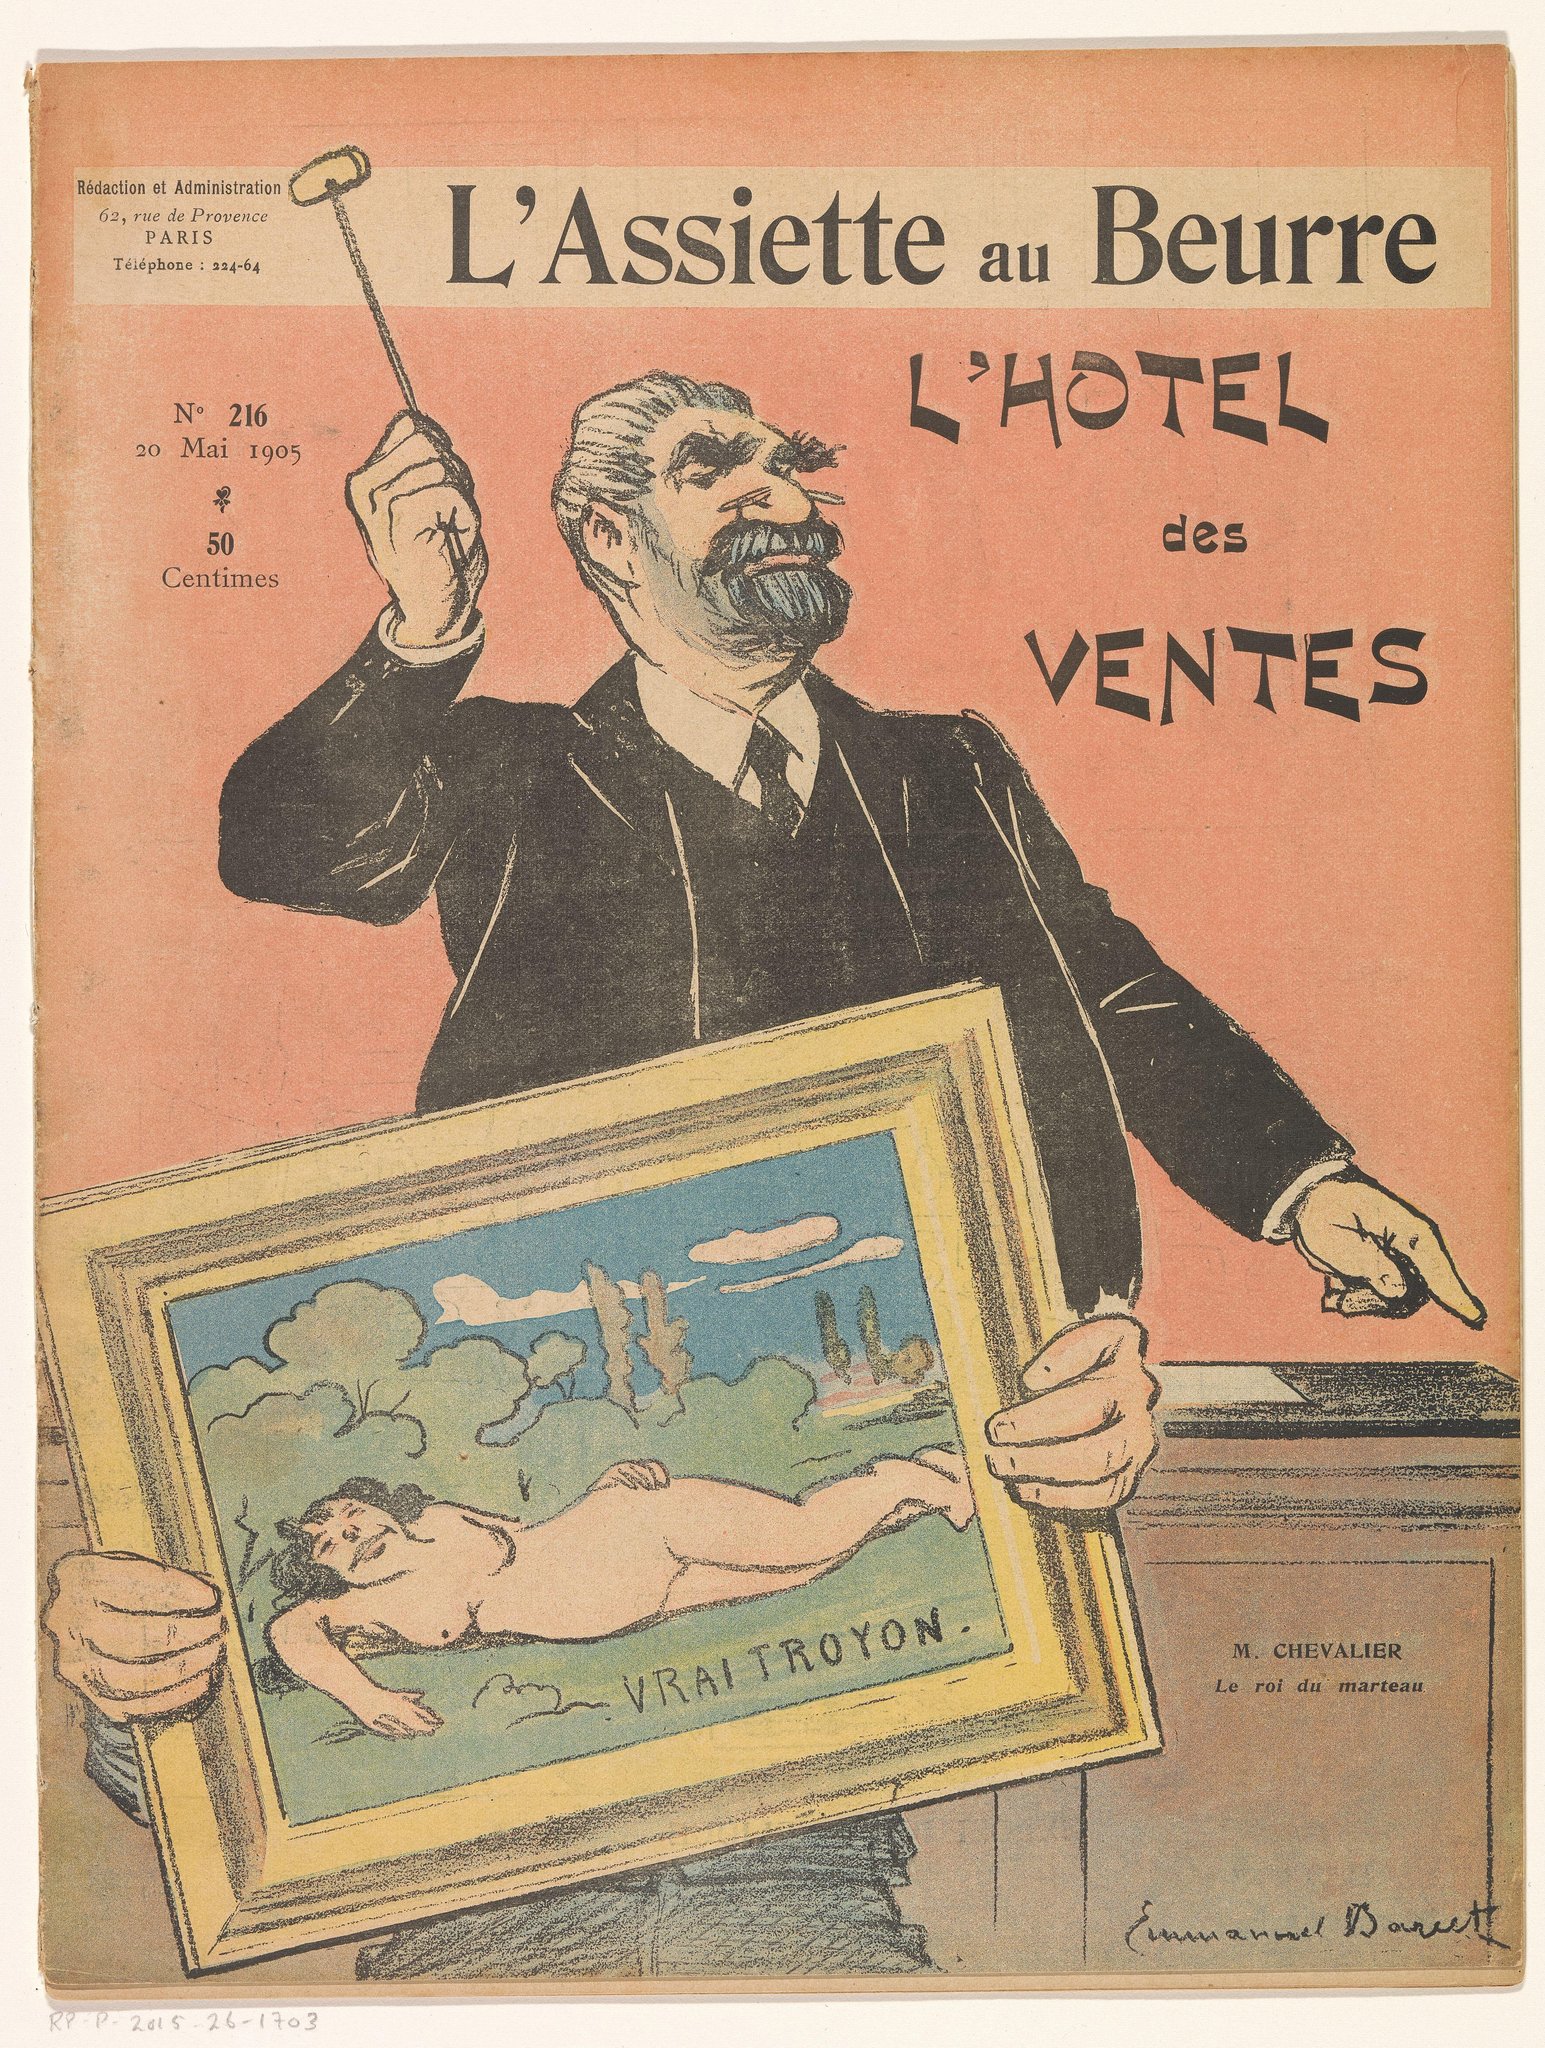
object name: magazine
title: L'Assiette au Beurre, themanummer gewijd aan het veilinghuis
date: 1905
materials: paper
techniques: lithograph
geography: paris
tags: auctioneer, caricatures (human types), picture, painting, art sale, auction, political caricatures and satires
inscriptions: collector's mark: Lugt 2228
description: Aflevering 216 van het Franse tijdschrift L'Assiette au Beurre, verschenen op 20 mei 1905. Het betreft een themanummer gewijd aan het veilinghuis (L'Hotel des ventes') met satirische illustraties naar ontwerp van Emmanuel Barcet. Op de voorkant een portret van veilingmeester Paul Chevallier met de hamer opgeheven in zijn rechterhand. Op de voorgrond wordt een schilderij getoond met een liggend vrouwelijk naakt in een landschap met de tekst 'Vrai Troyon', een verwijzing naar de schilder Constant Troyon.